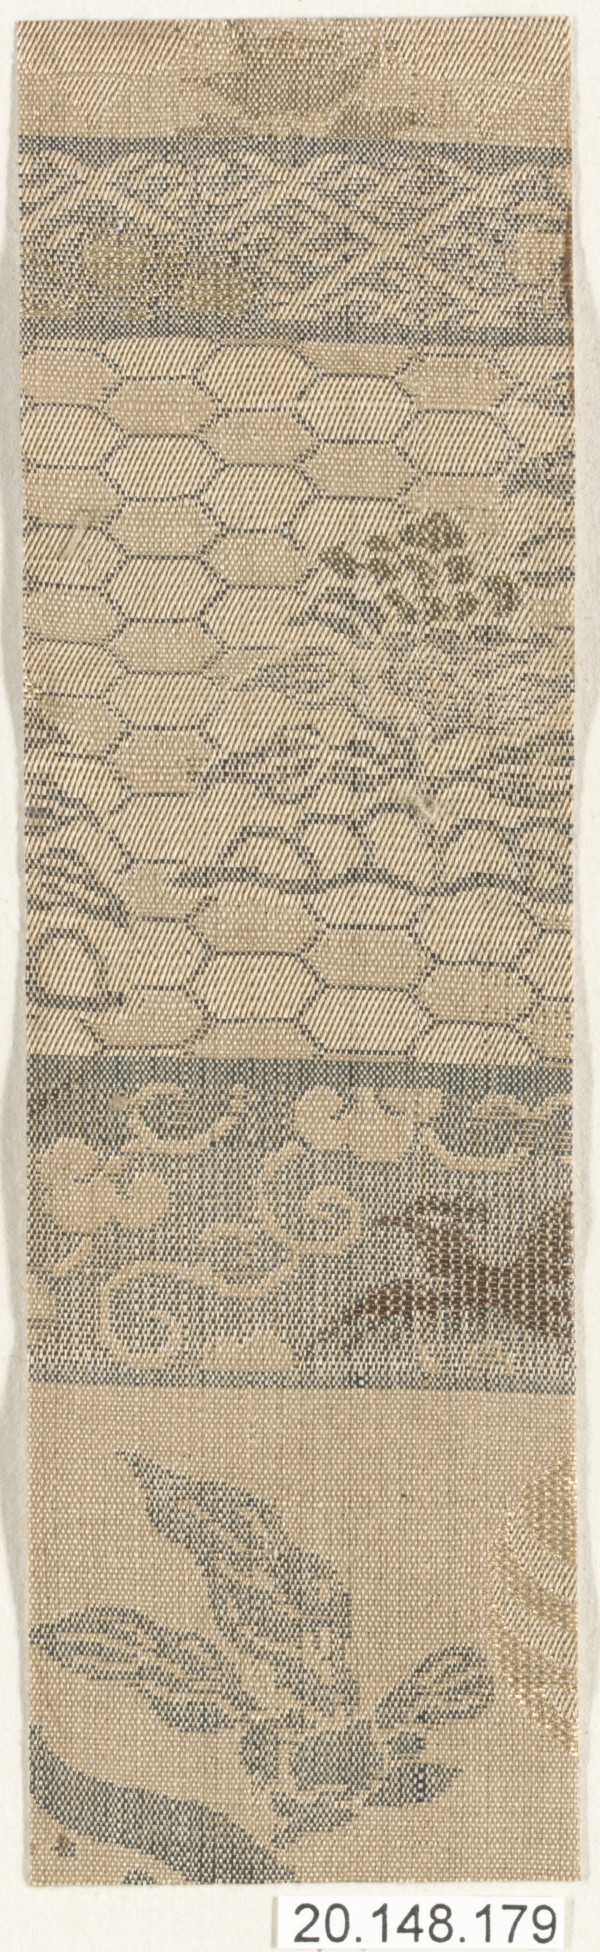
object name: piece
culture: japanese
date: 1701-1800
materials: silk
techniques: compound weave